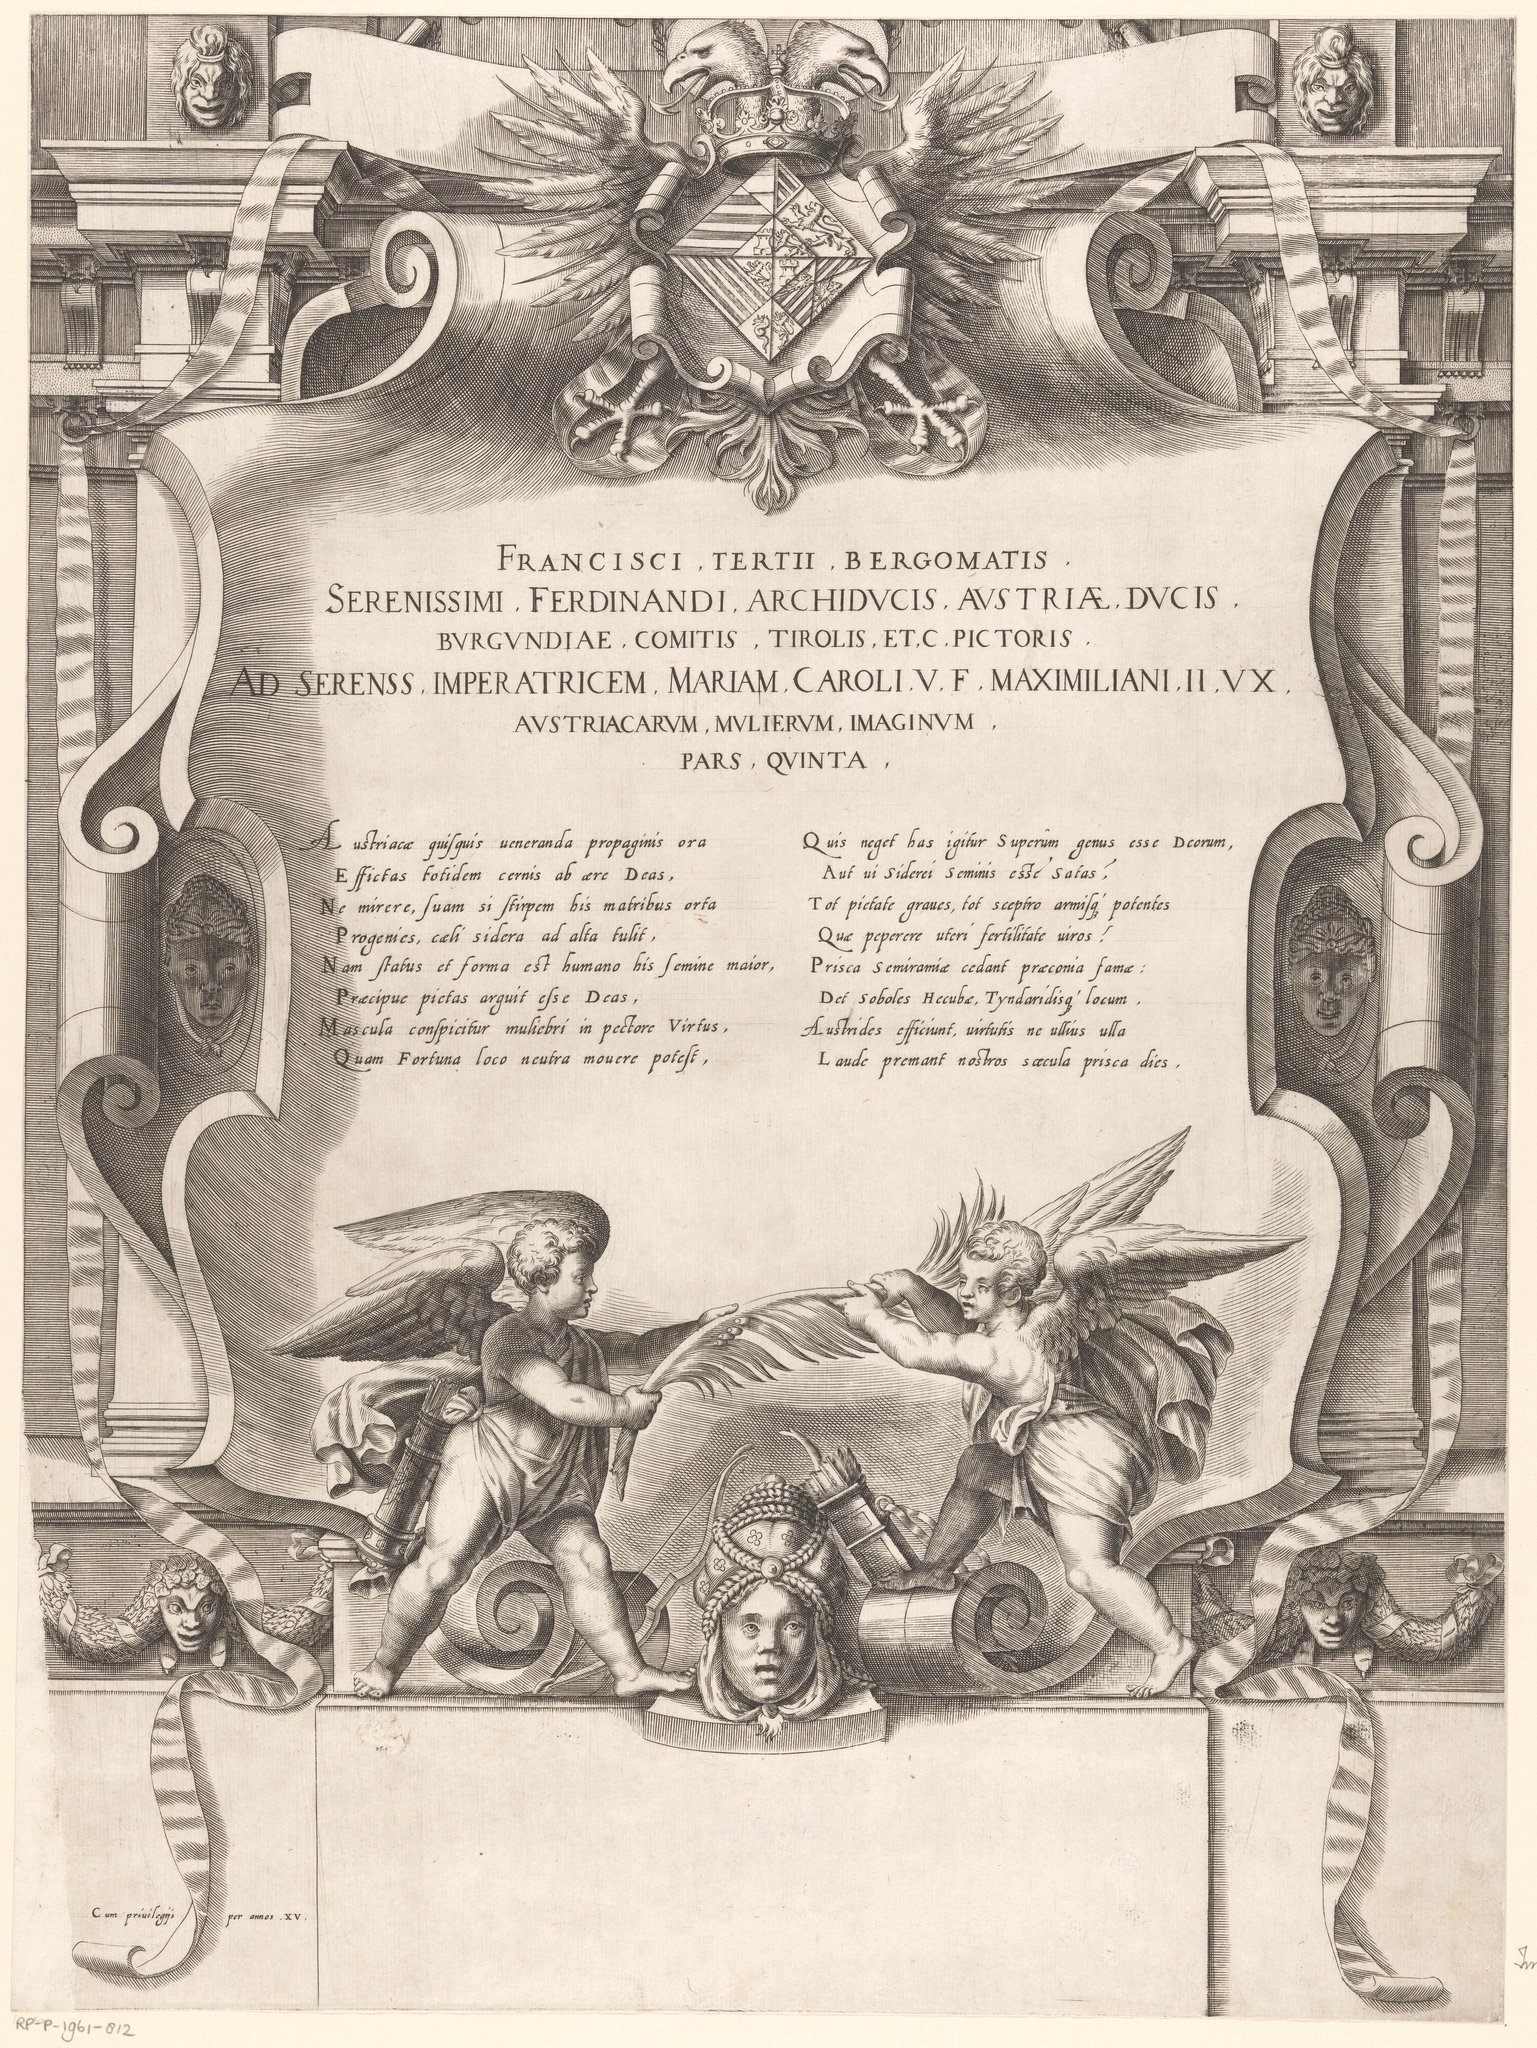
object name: print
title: Portretten van leden van het Oostenrijkse Huis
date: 1569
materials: paper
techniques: engraving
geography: italy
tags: coat of arms (symbol of sovereignty), ornaments ~ art, cupids: 'amores', 'amoretti', 'putti'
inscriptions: collector's mark: Lugt 2228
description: Deze prent maakt deel uit van een reeks van 58 prenten. Het meerendeel van de prenten bevat portretten van 74 leden van het Oostenrijkse Huis, naar tekeningen door Francesco Terzio, die deels getekend zijn naar de 28 levensgrote bronzen beelden die rond de cenotaaf van Maximiliaan I in de Hofkirche te Innsbruck staan.